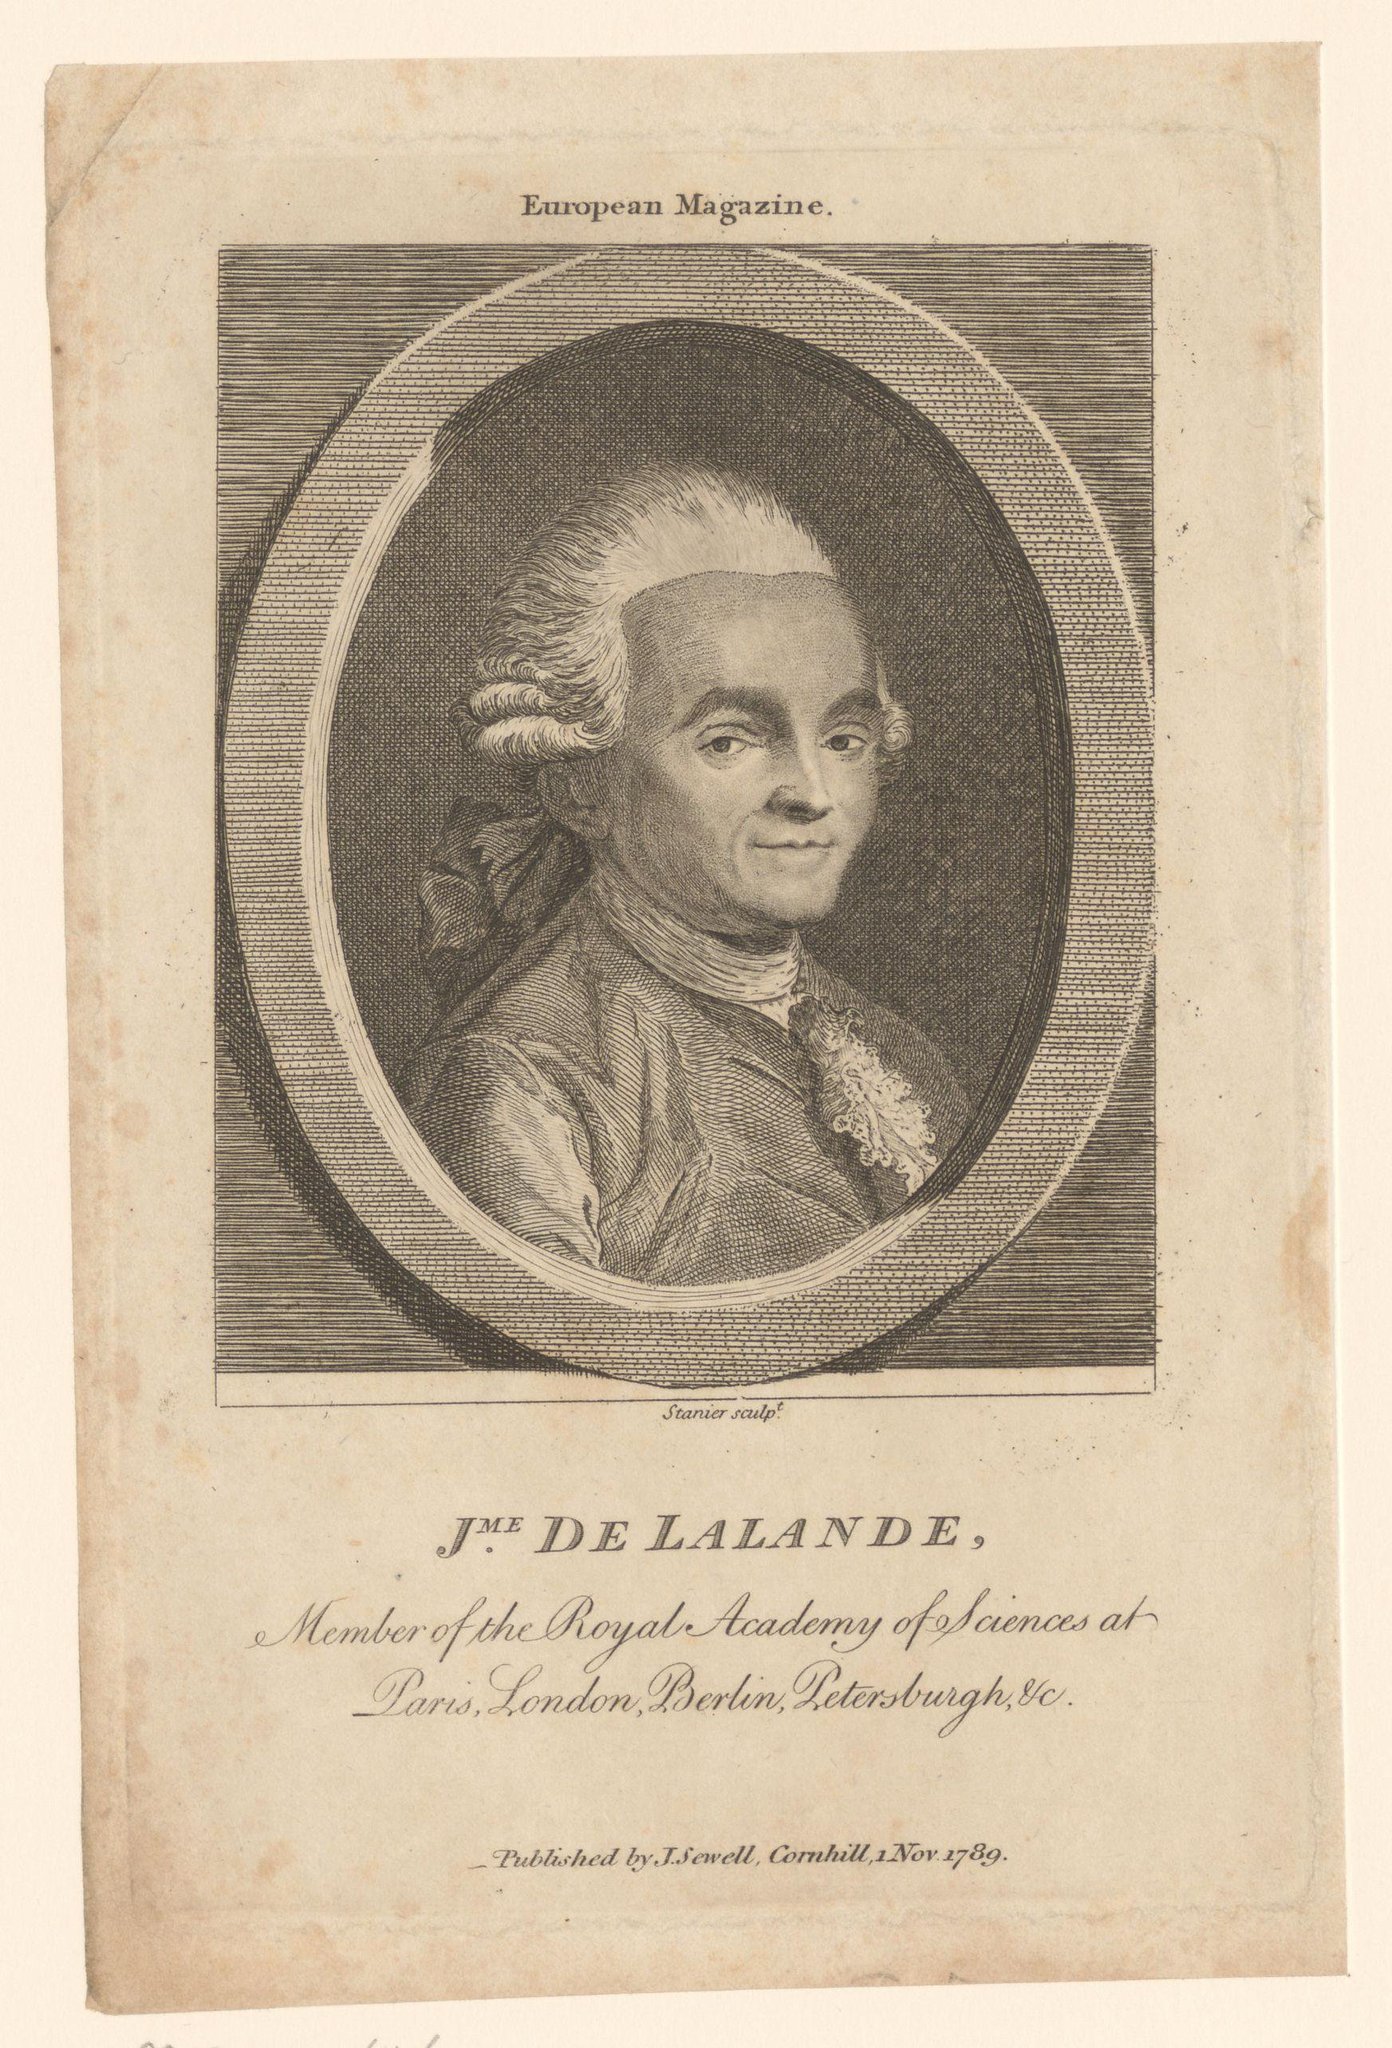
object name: print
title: Jme. De Lalande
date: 1711-1789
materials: paper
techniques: etching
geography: london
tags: paris, astronomy (and cosmography) (+ portrait of scholar, scientist), historical persons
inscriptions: collector's mark: Lugt 2228